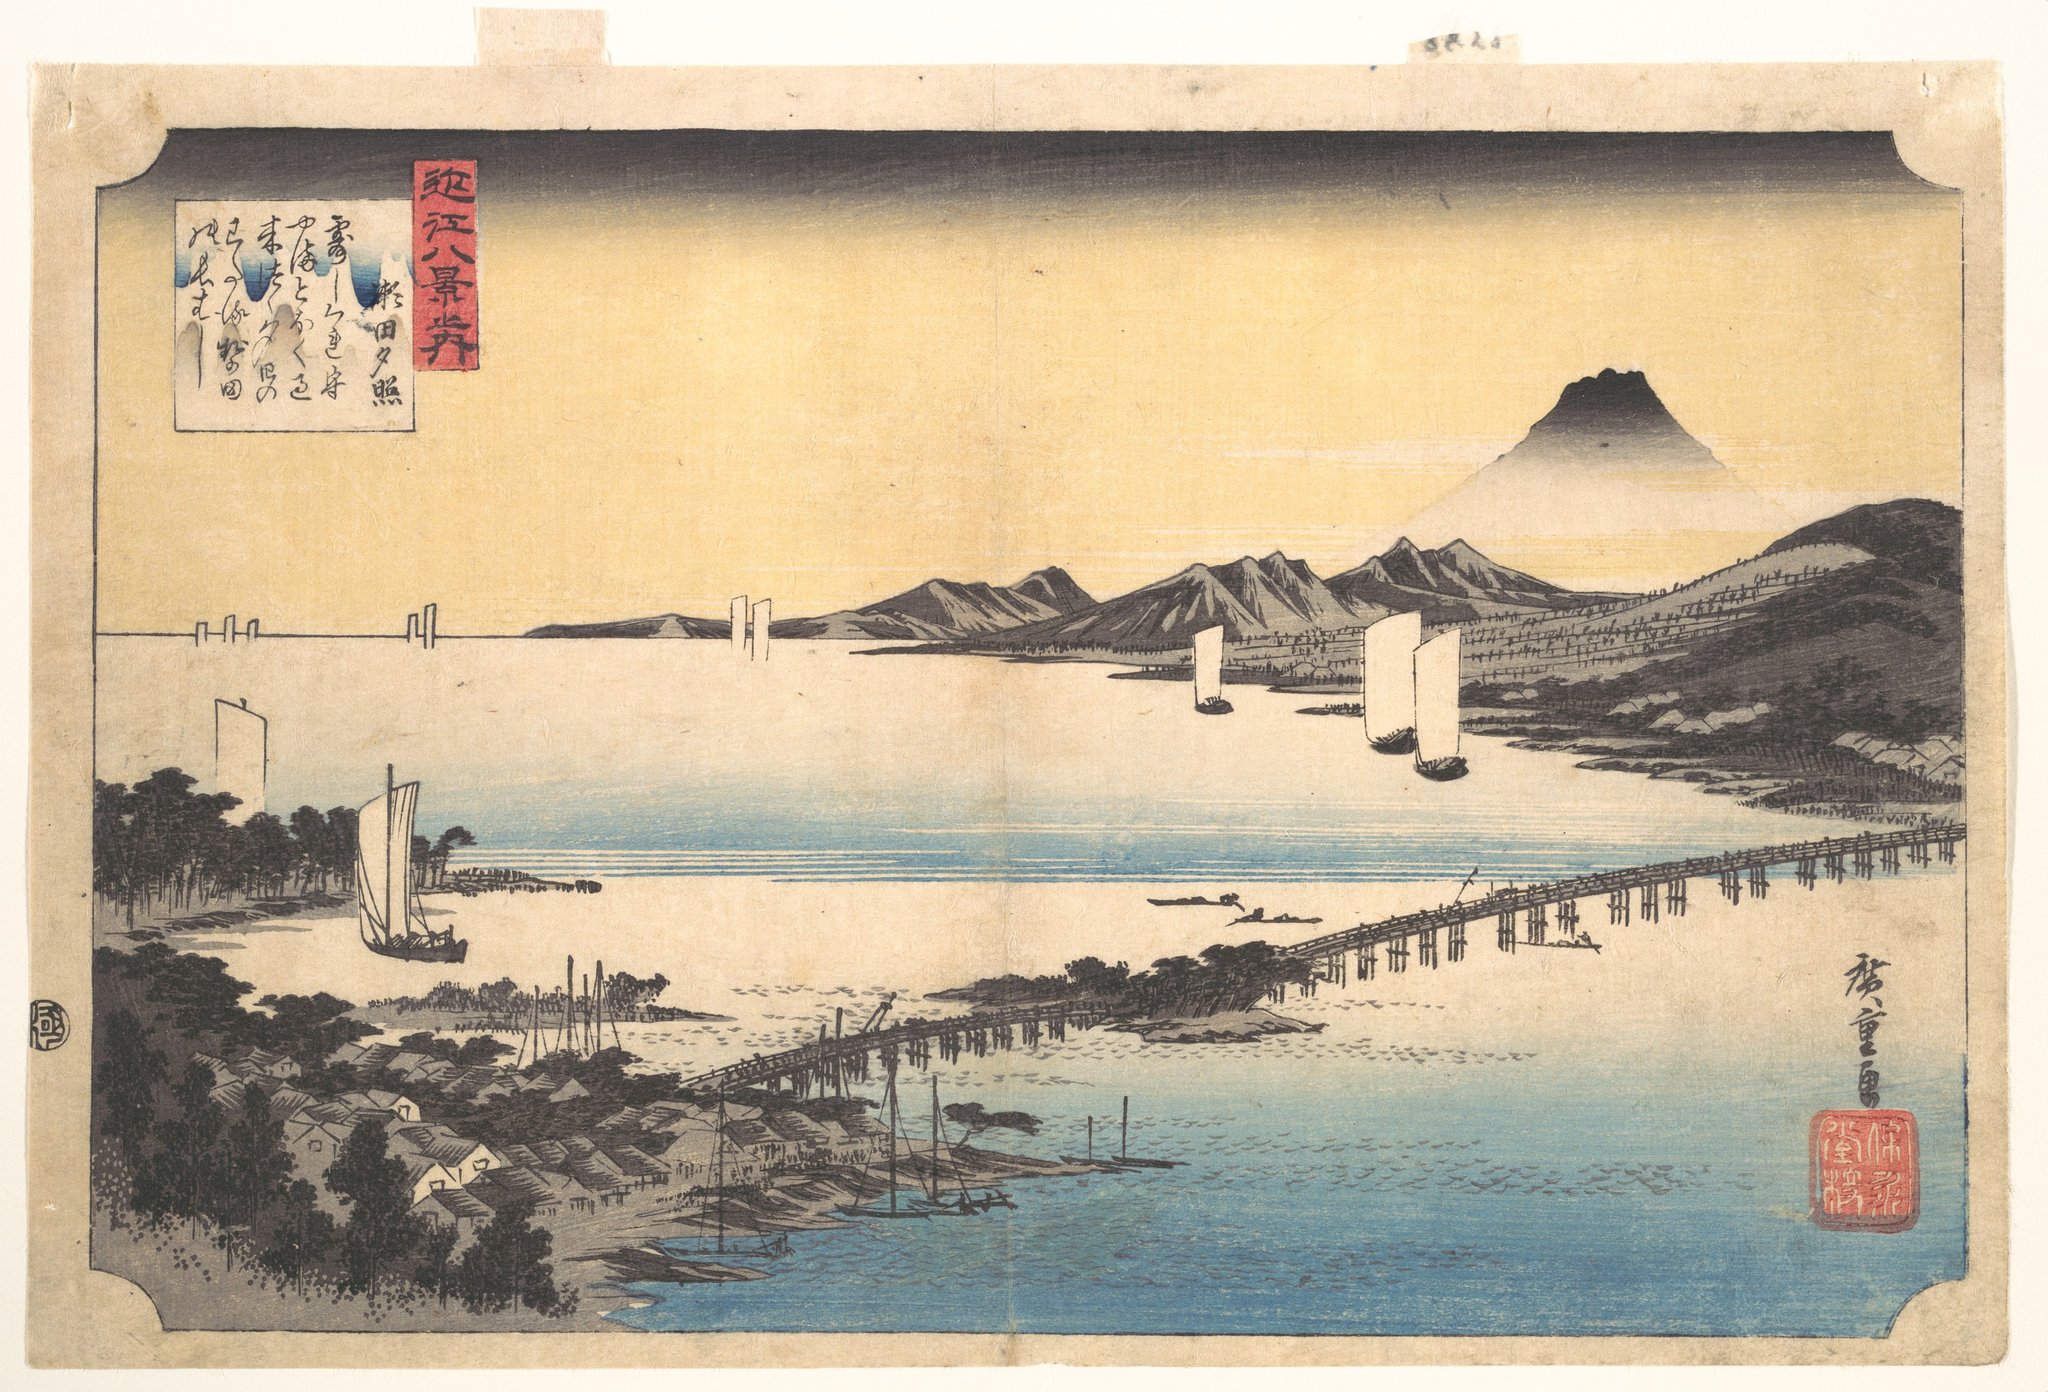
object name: print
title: Sunset Glow at Seta (Seta sekishō), from the series Eight Views of Ōmi Province (Ōmi hakkei)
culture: japanese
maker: utagawa hiroshige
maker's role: artist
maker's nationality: japanese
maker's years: 1797-1858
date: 1834-1835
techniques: woodblock print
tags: bridges,mountains,seascapes,boats